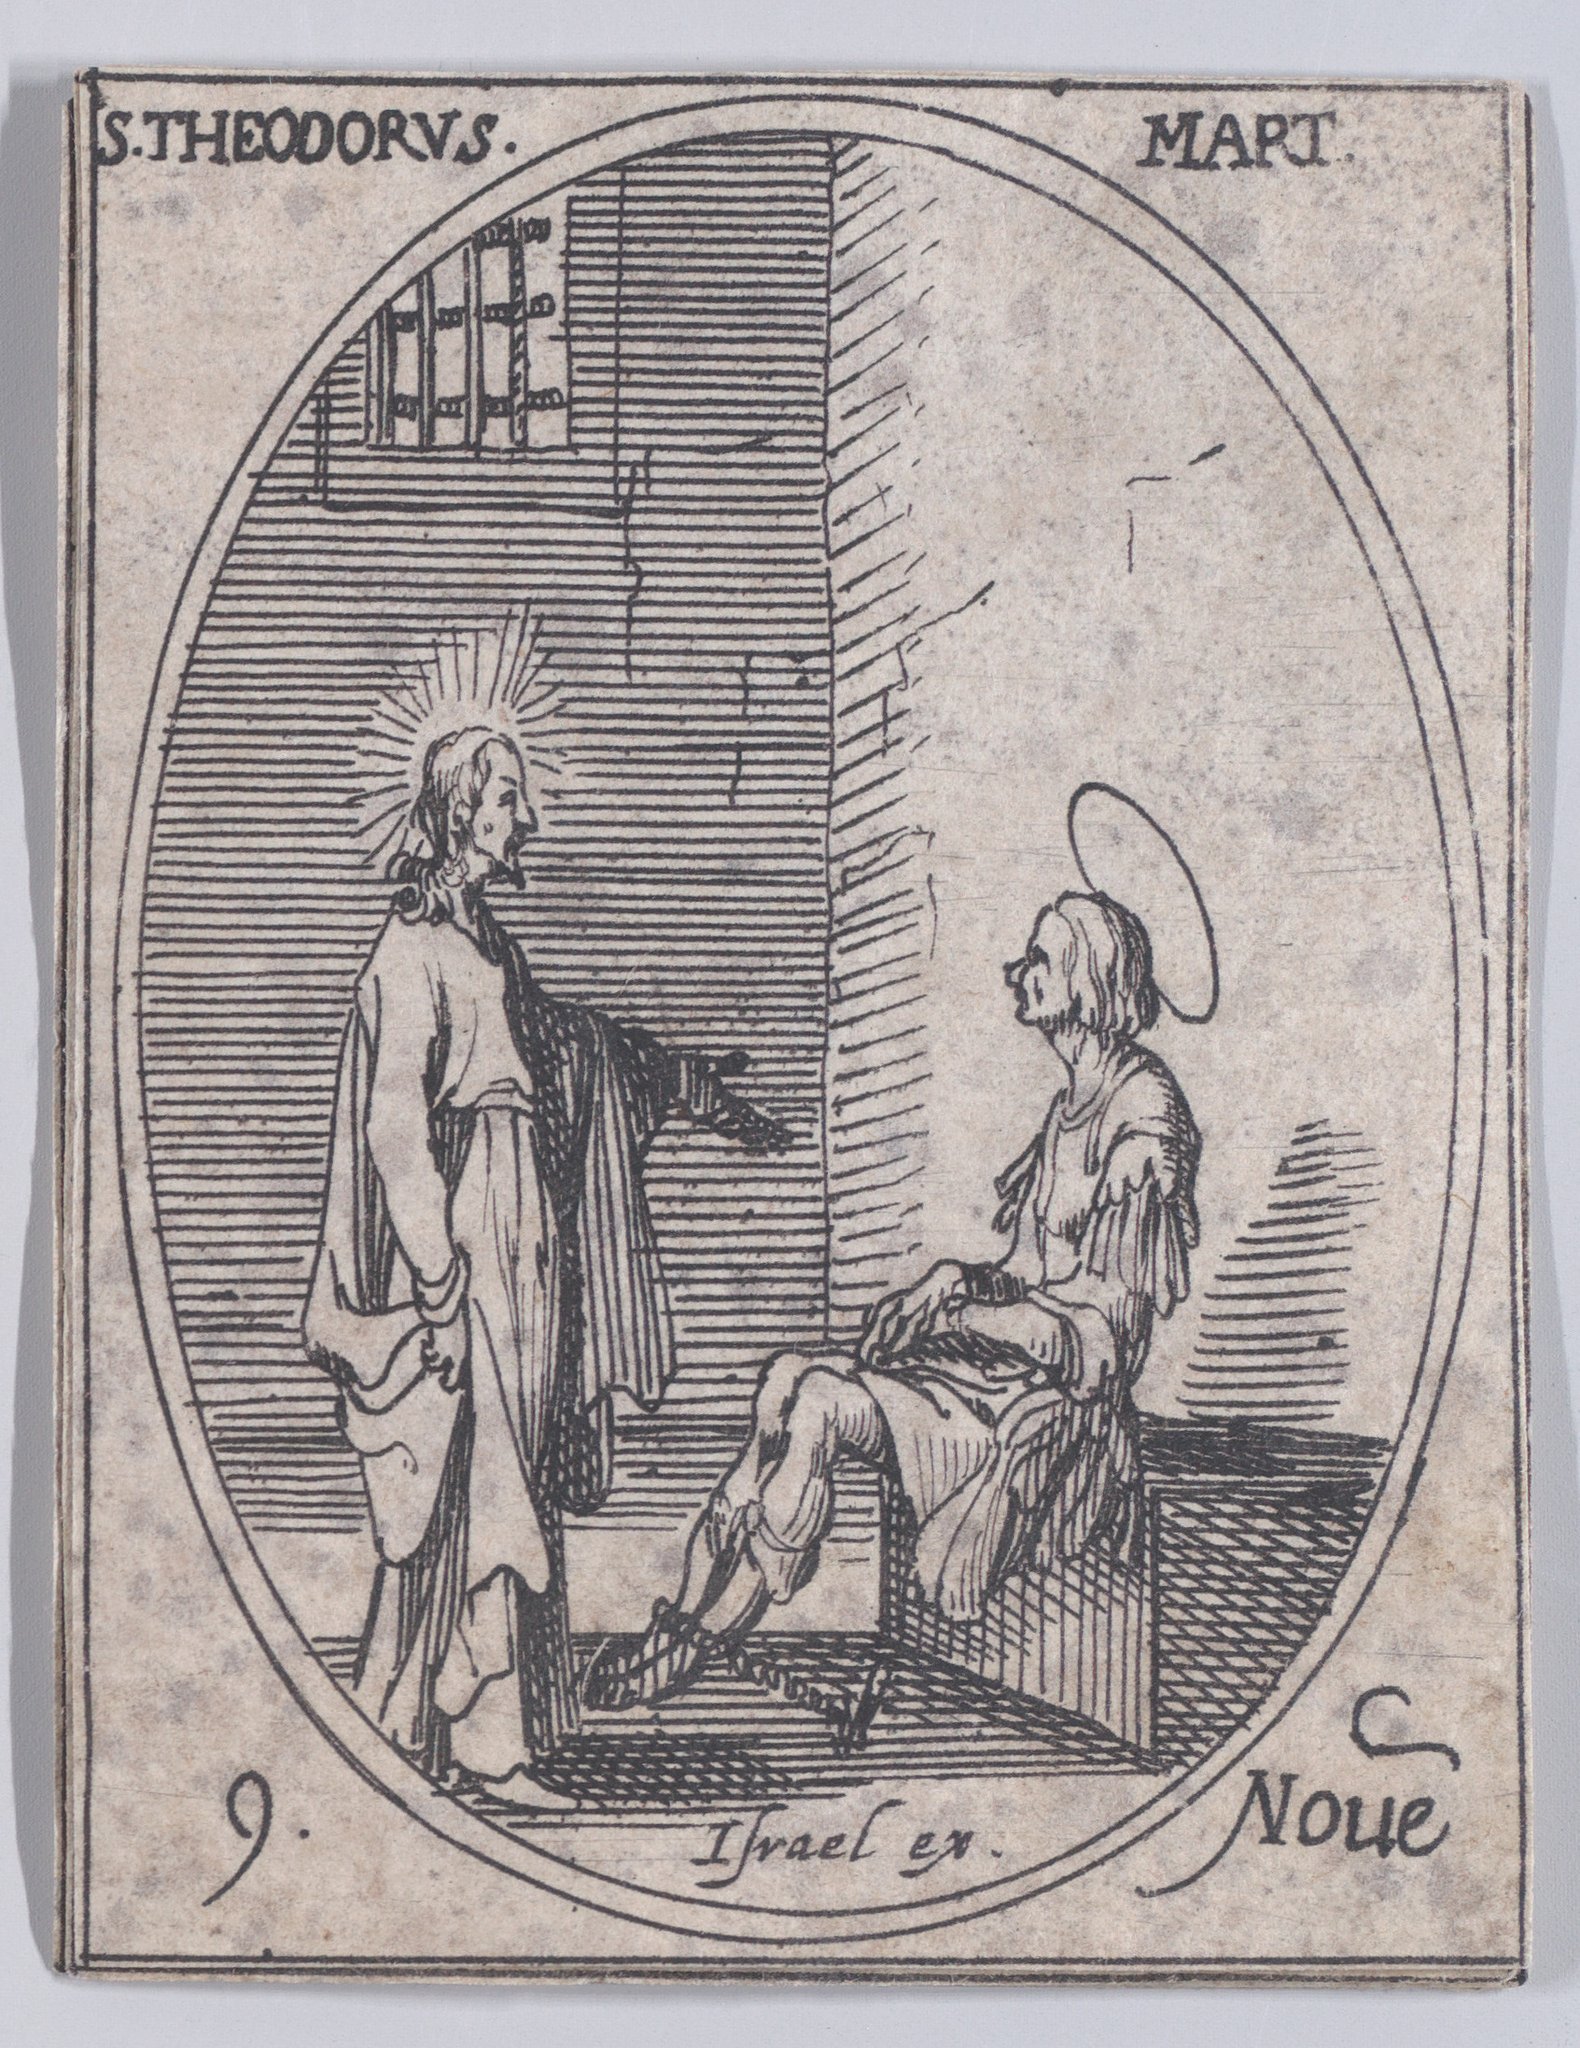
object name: print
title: S. Théodore, martyr (St. Theodore Stratelates, Martyr), November 9th, from "Les Images De Tous Les Saincts et Saintes de L'Année" (Images of All of the Saints and Religious Events of the Year)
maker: jacques callot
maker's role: artist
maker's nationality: french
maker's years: 1592-1635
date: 1636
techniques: etching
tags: men,saints